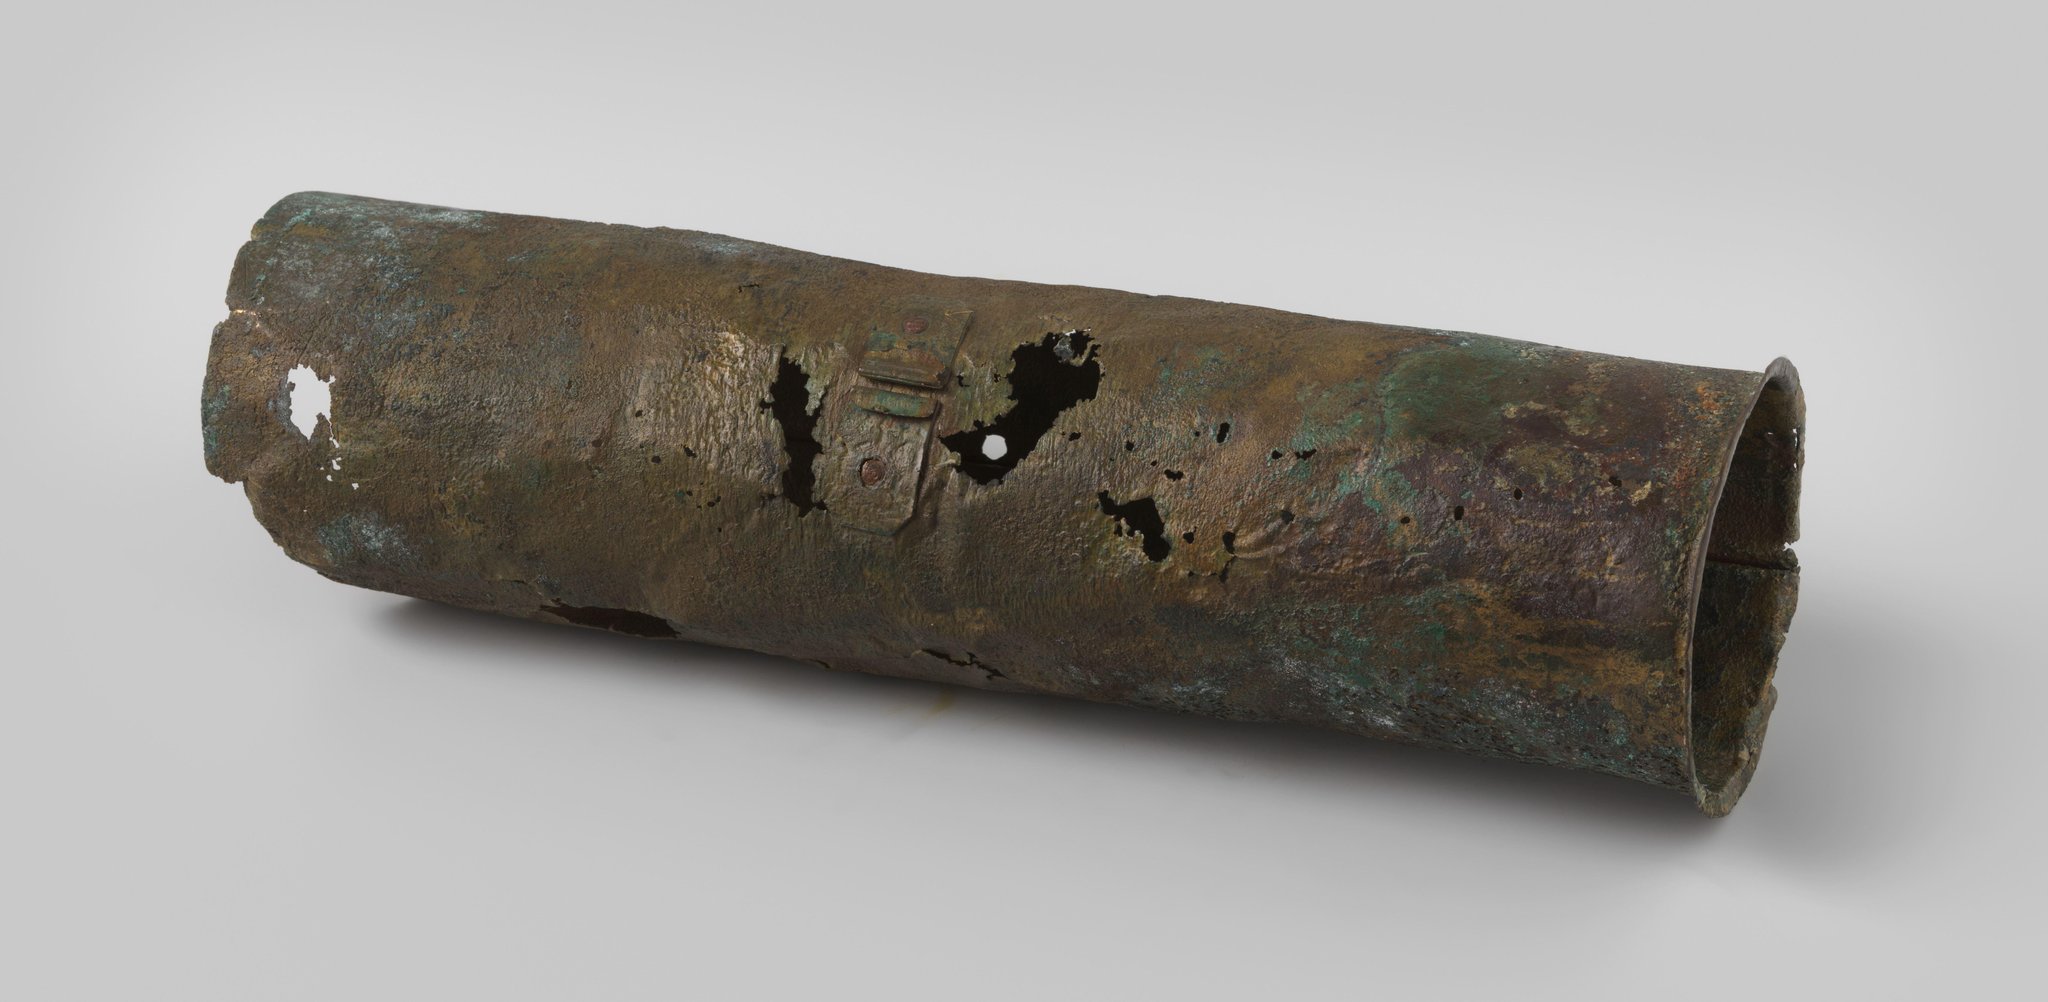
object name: cartridge canister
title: Kardoeskoker uit het wrak van de Oost-Indiëvaarder Hollandia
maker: Anonymous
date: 1700-1743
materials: copper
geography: netherlands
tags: verenigde oostindische compagnie, hollandia (schip), annet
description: Cartridge canister; fragm: straight cylinder of rolled sheet, eroded, longitudinal fold-over seam, narrow flanged rim on lower end, base missing, in the centre two vertical tube-shaped fittings on diametrically opposite sides (id. NG 1980-27H2394).